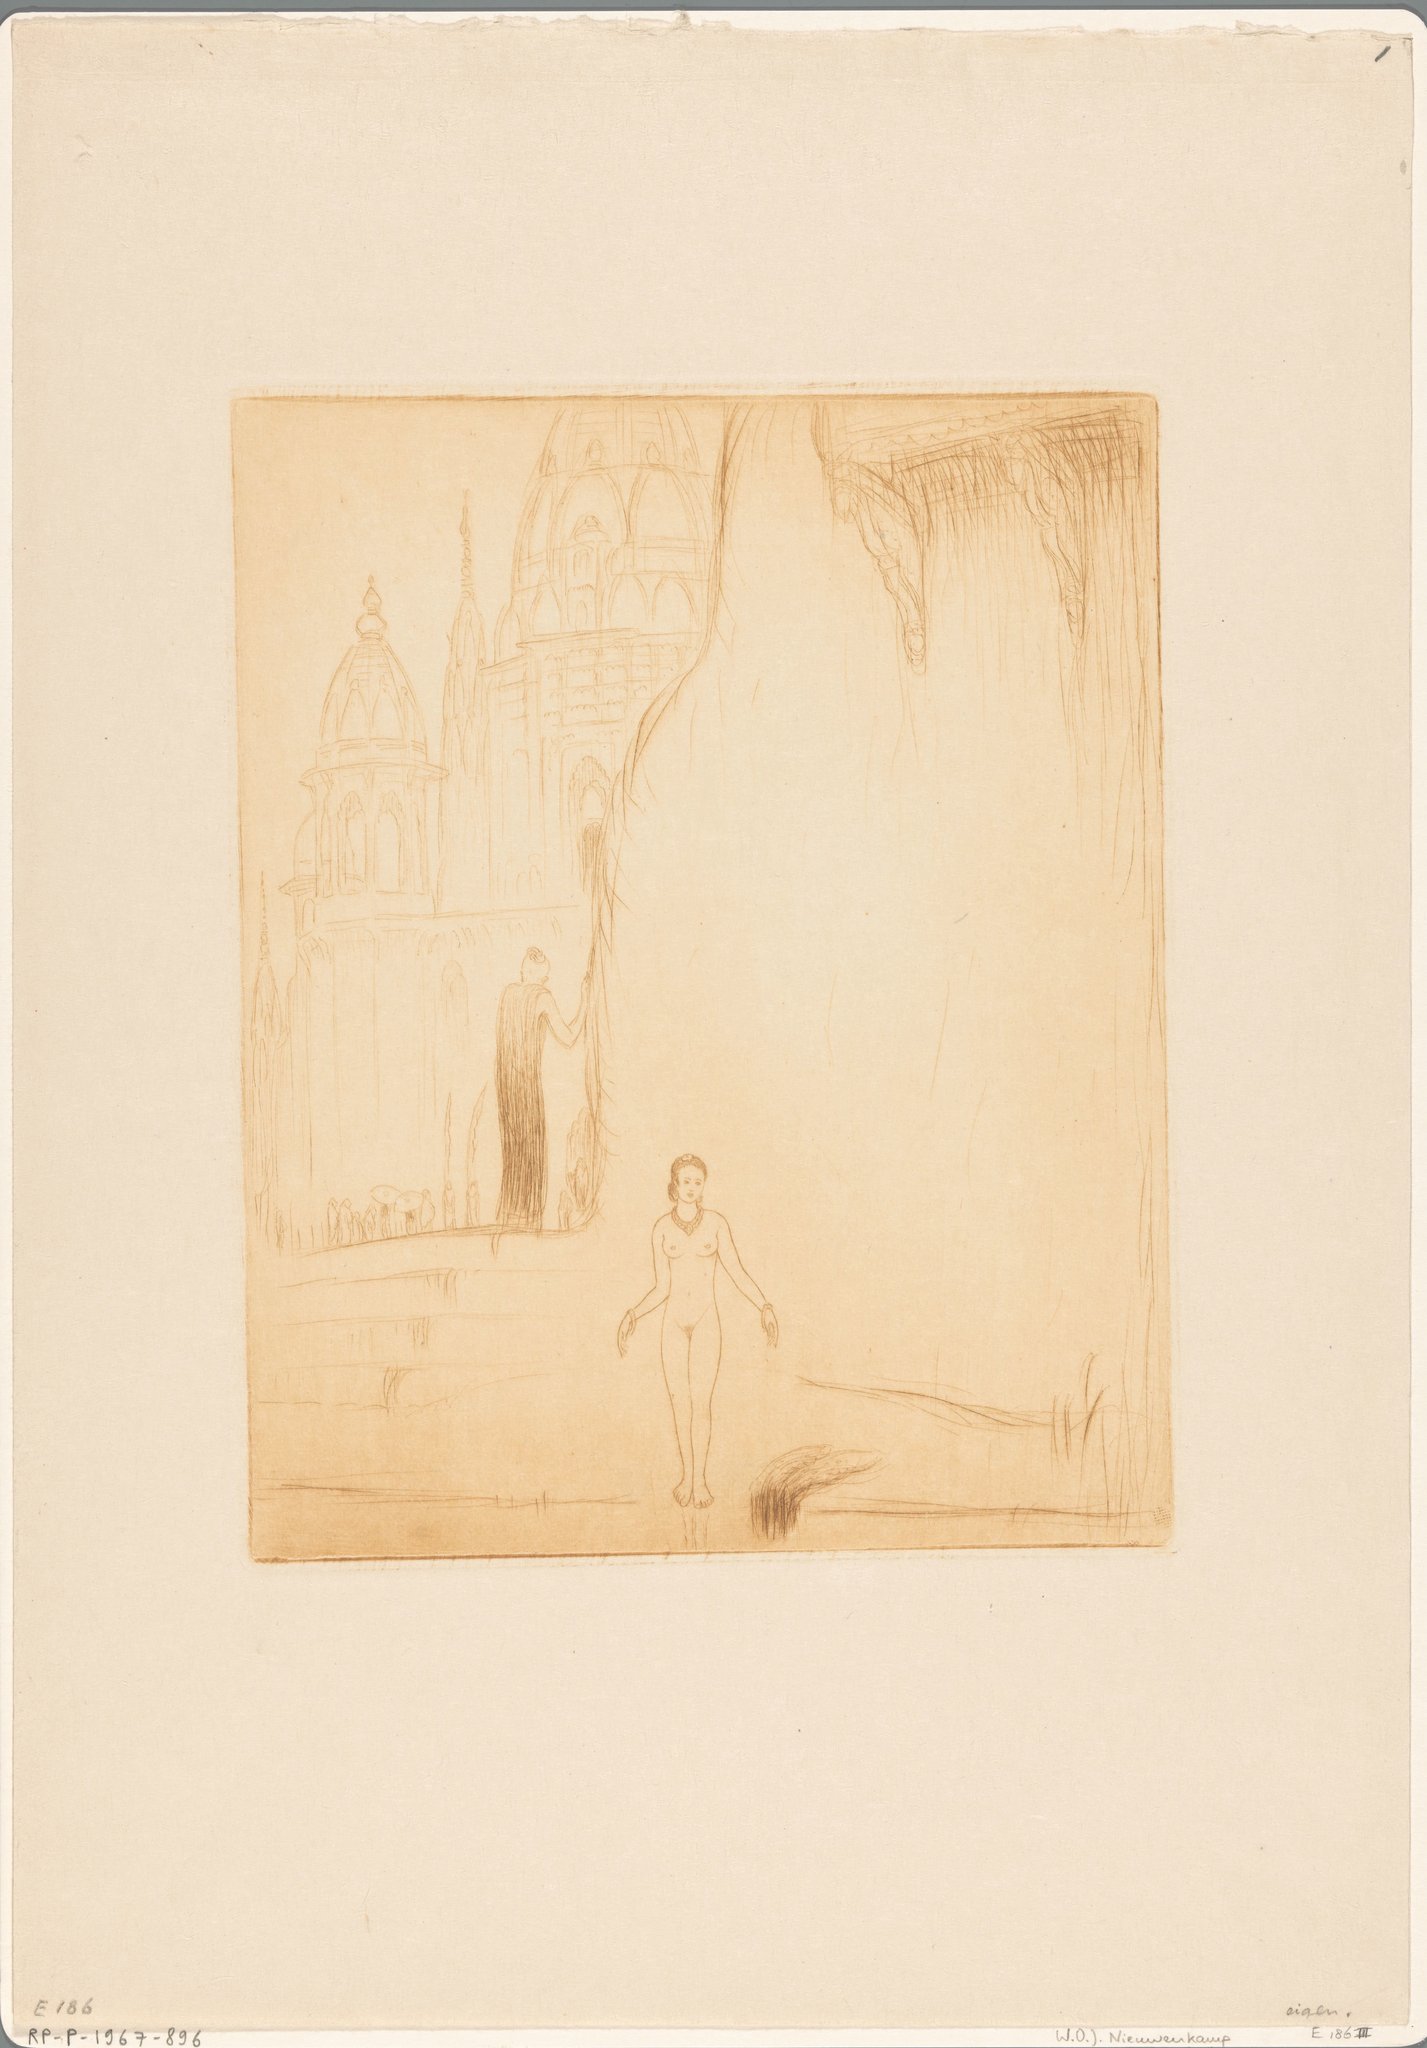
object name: print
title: Badend meisje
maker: wijnand otto jan nieuwenkamp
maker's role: draughtsman, print maker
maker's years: 1874-1950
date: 1917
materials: paper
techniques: drypoint, intaglio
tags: woman (showing herself) undressed, quasi-nude, taking a bath - aa - in the open air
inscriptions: collector's mark: Lugt 2228, collector's mark: Lugt 2760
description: Bij deze derde staat van de prent is er op de achtergrond onder meer een tempel toegevoegd.